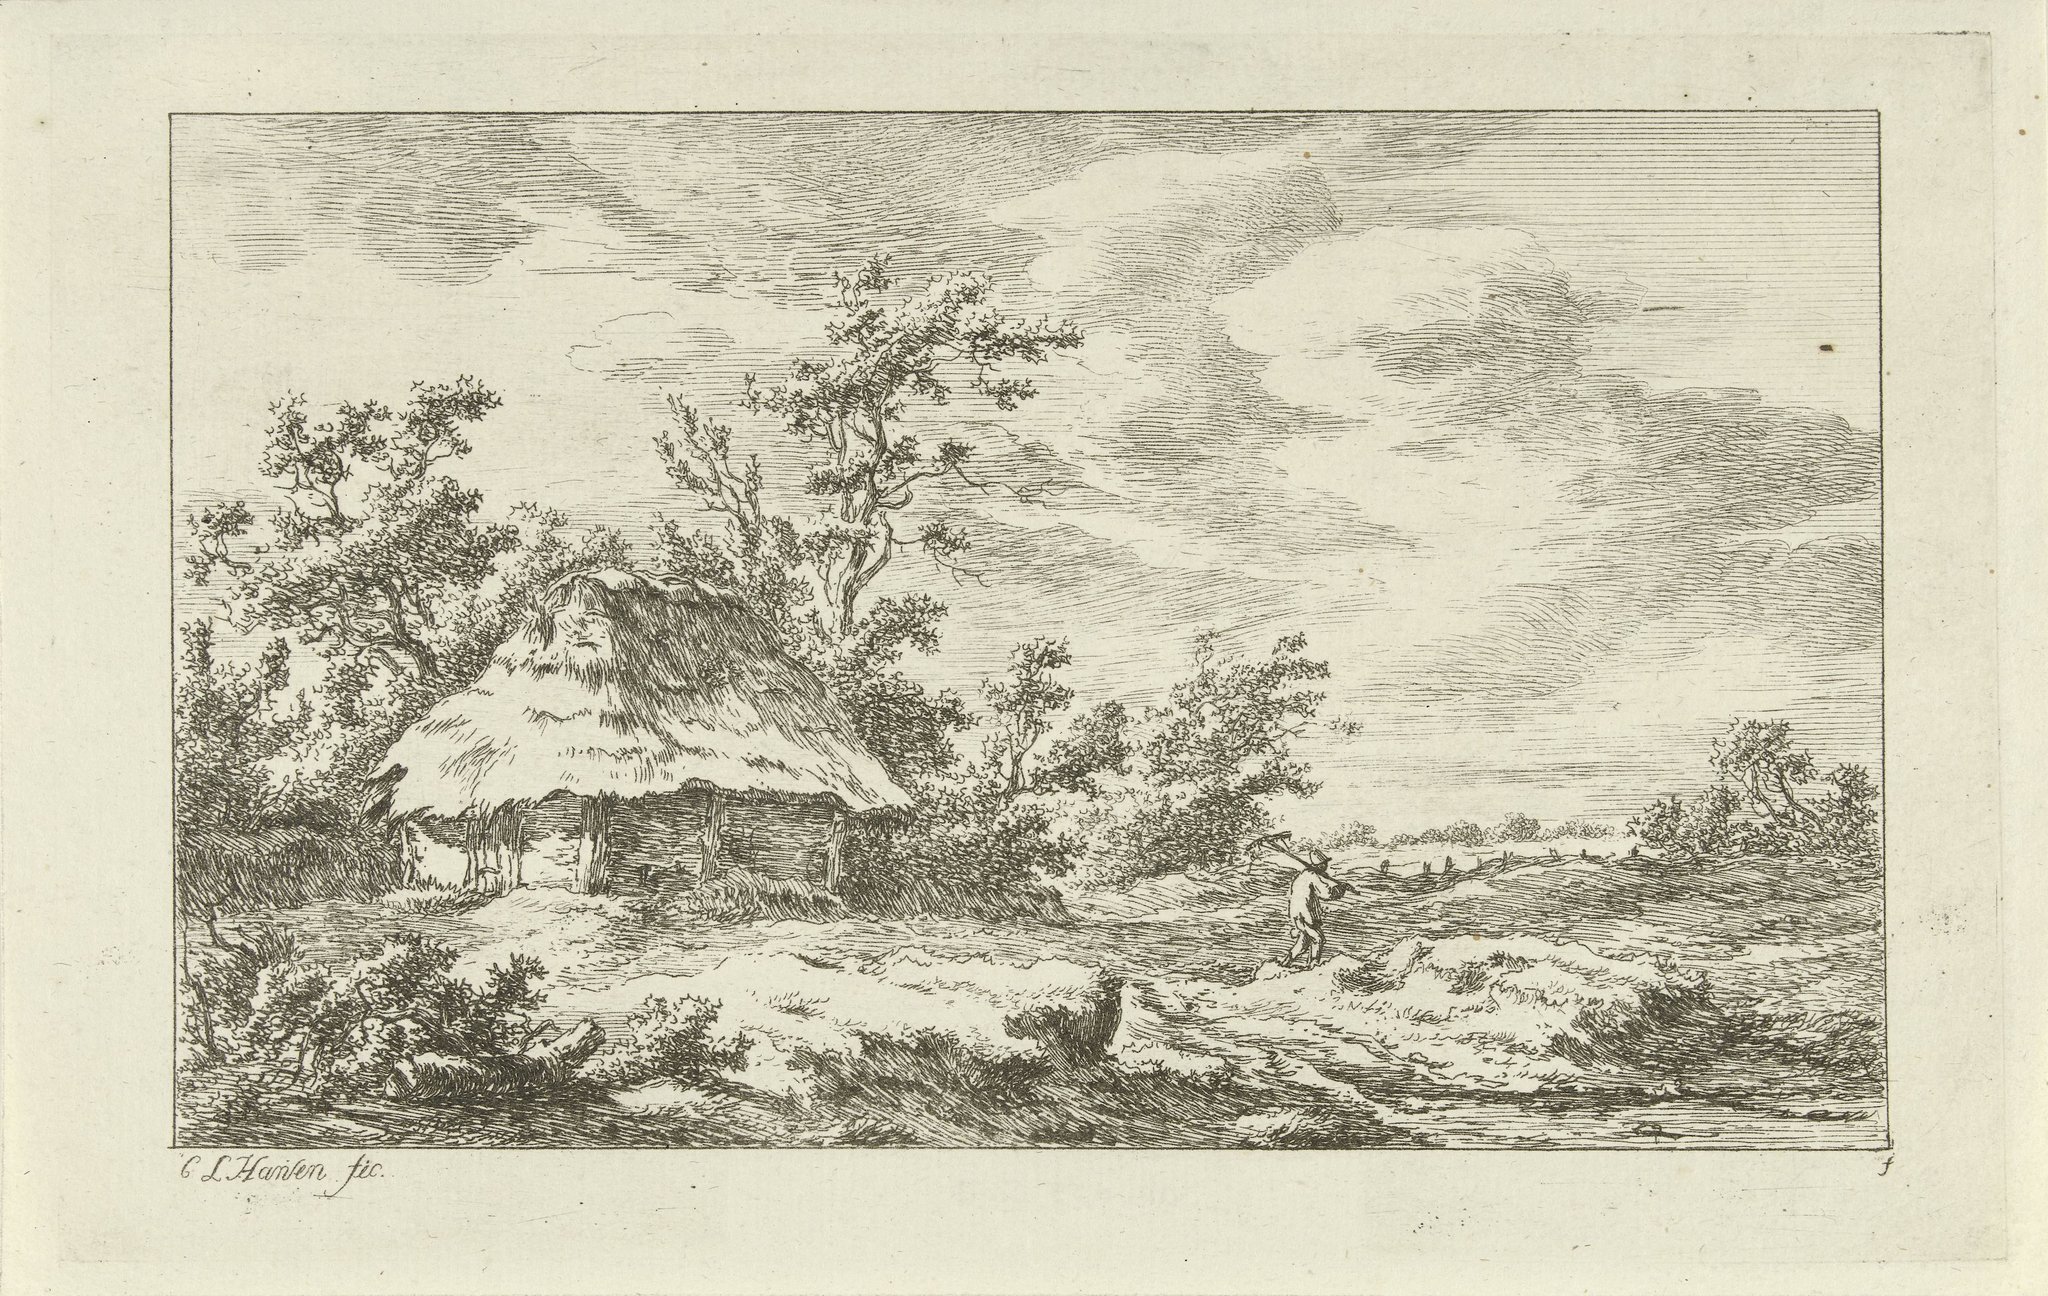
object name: print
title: Man met hark bij een schuur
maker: carel lodewijk hansen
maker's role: draughtsman, painter, print maker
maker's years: 1765-1840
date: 1780-1840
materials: paper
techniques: etching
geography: netherlands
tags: barn, landscapes (+ landscape with figures, staffage), agricultural implements: rake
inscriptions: collector's mark: Lugt 2228